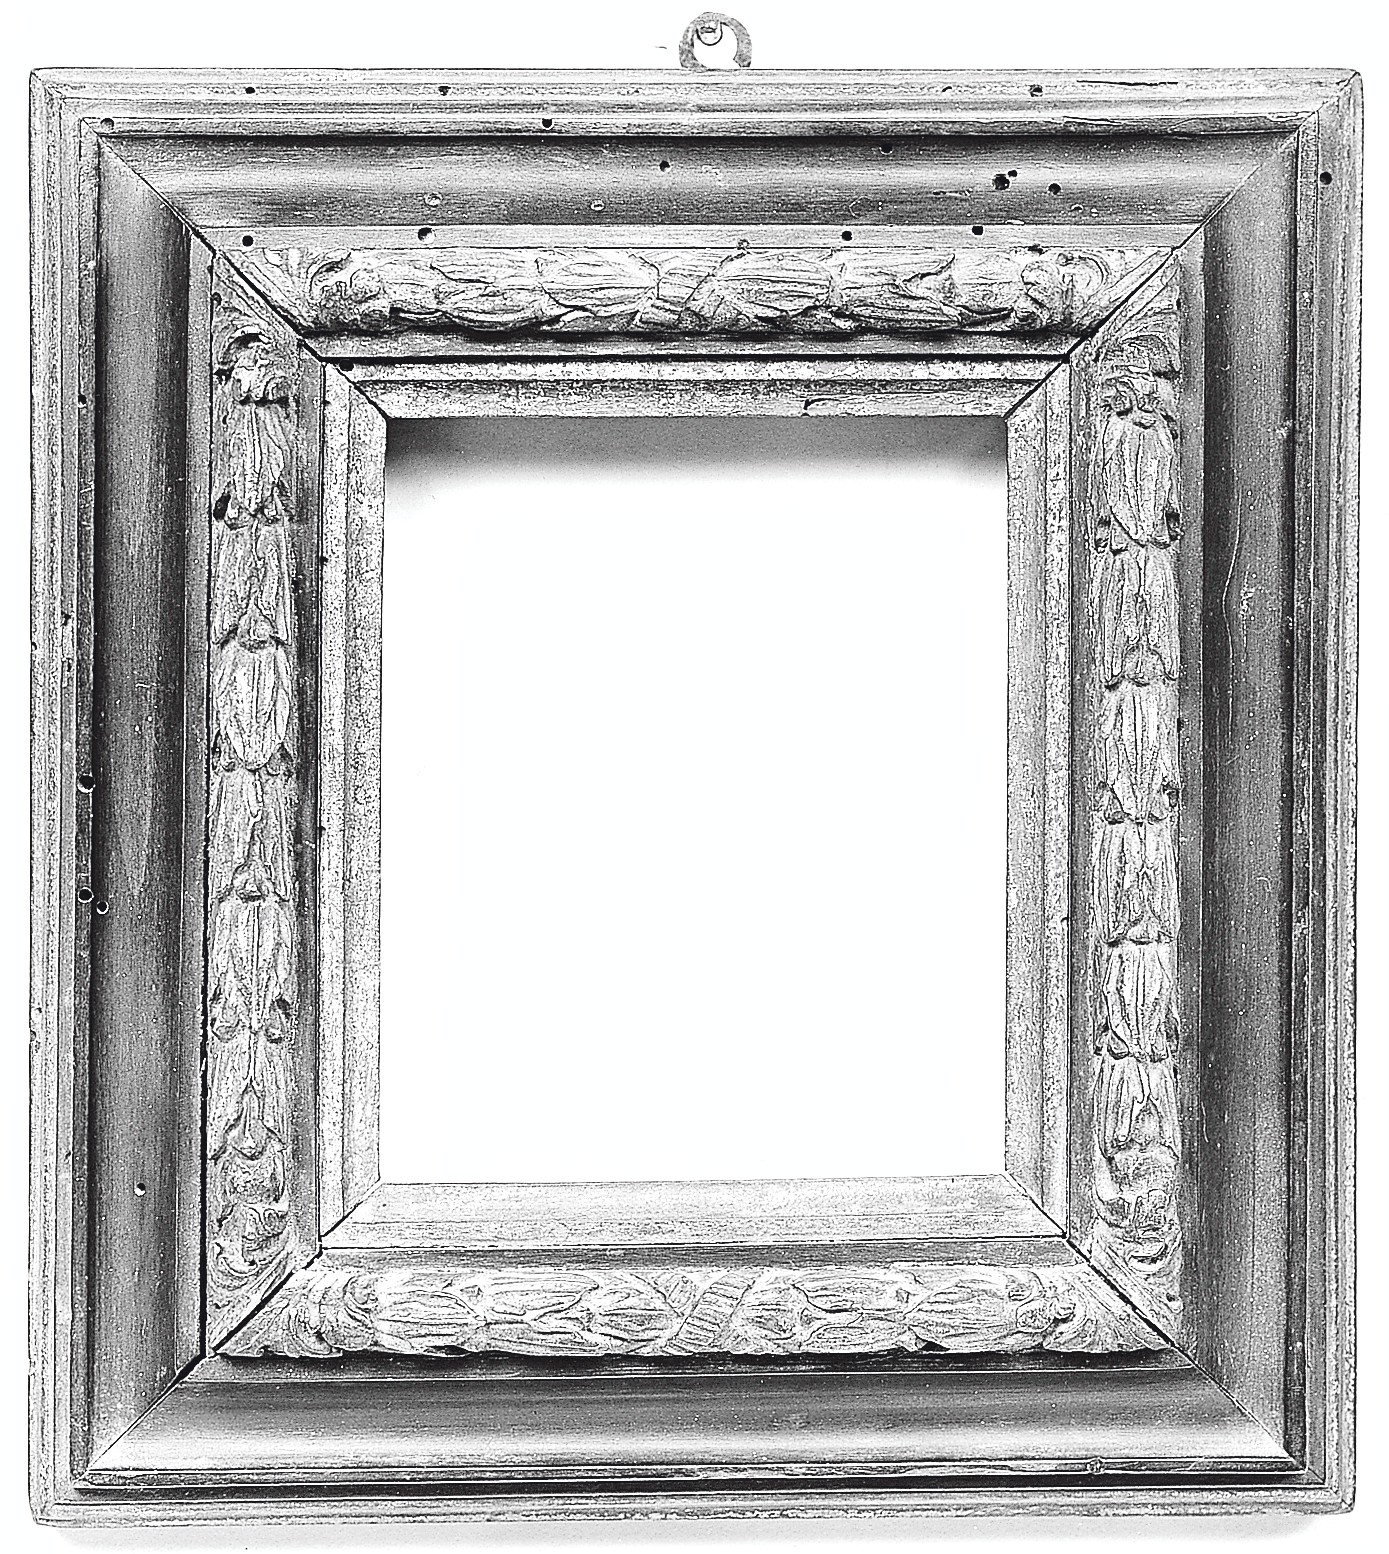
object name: frame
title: Cassetta frame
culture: italian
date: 1767-1800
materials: wood